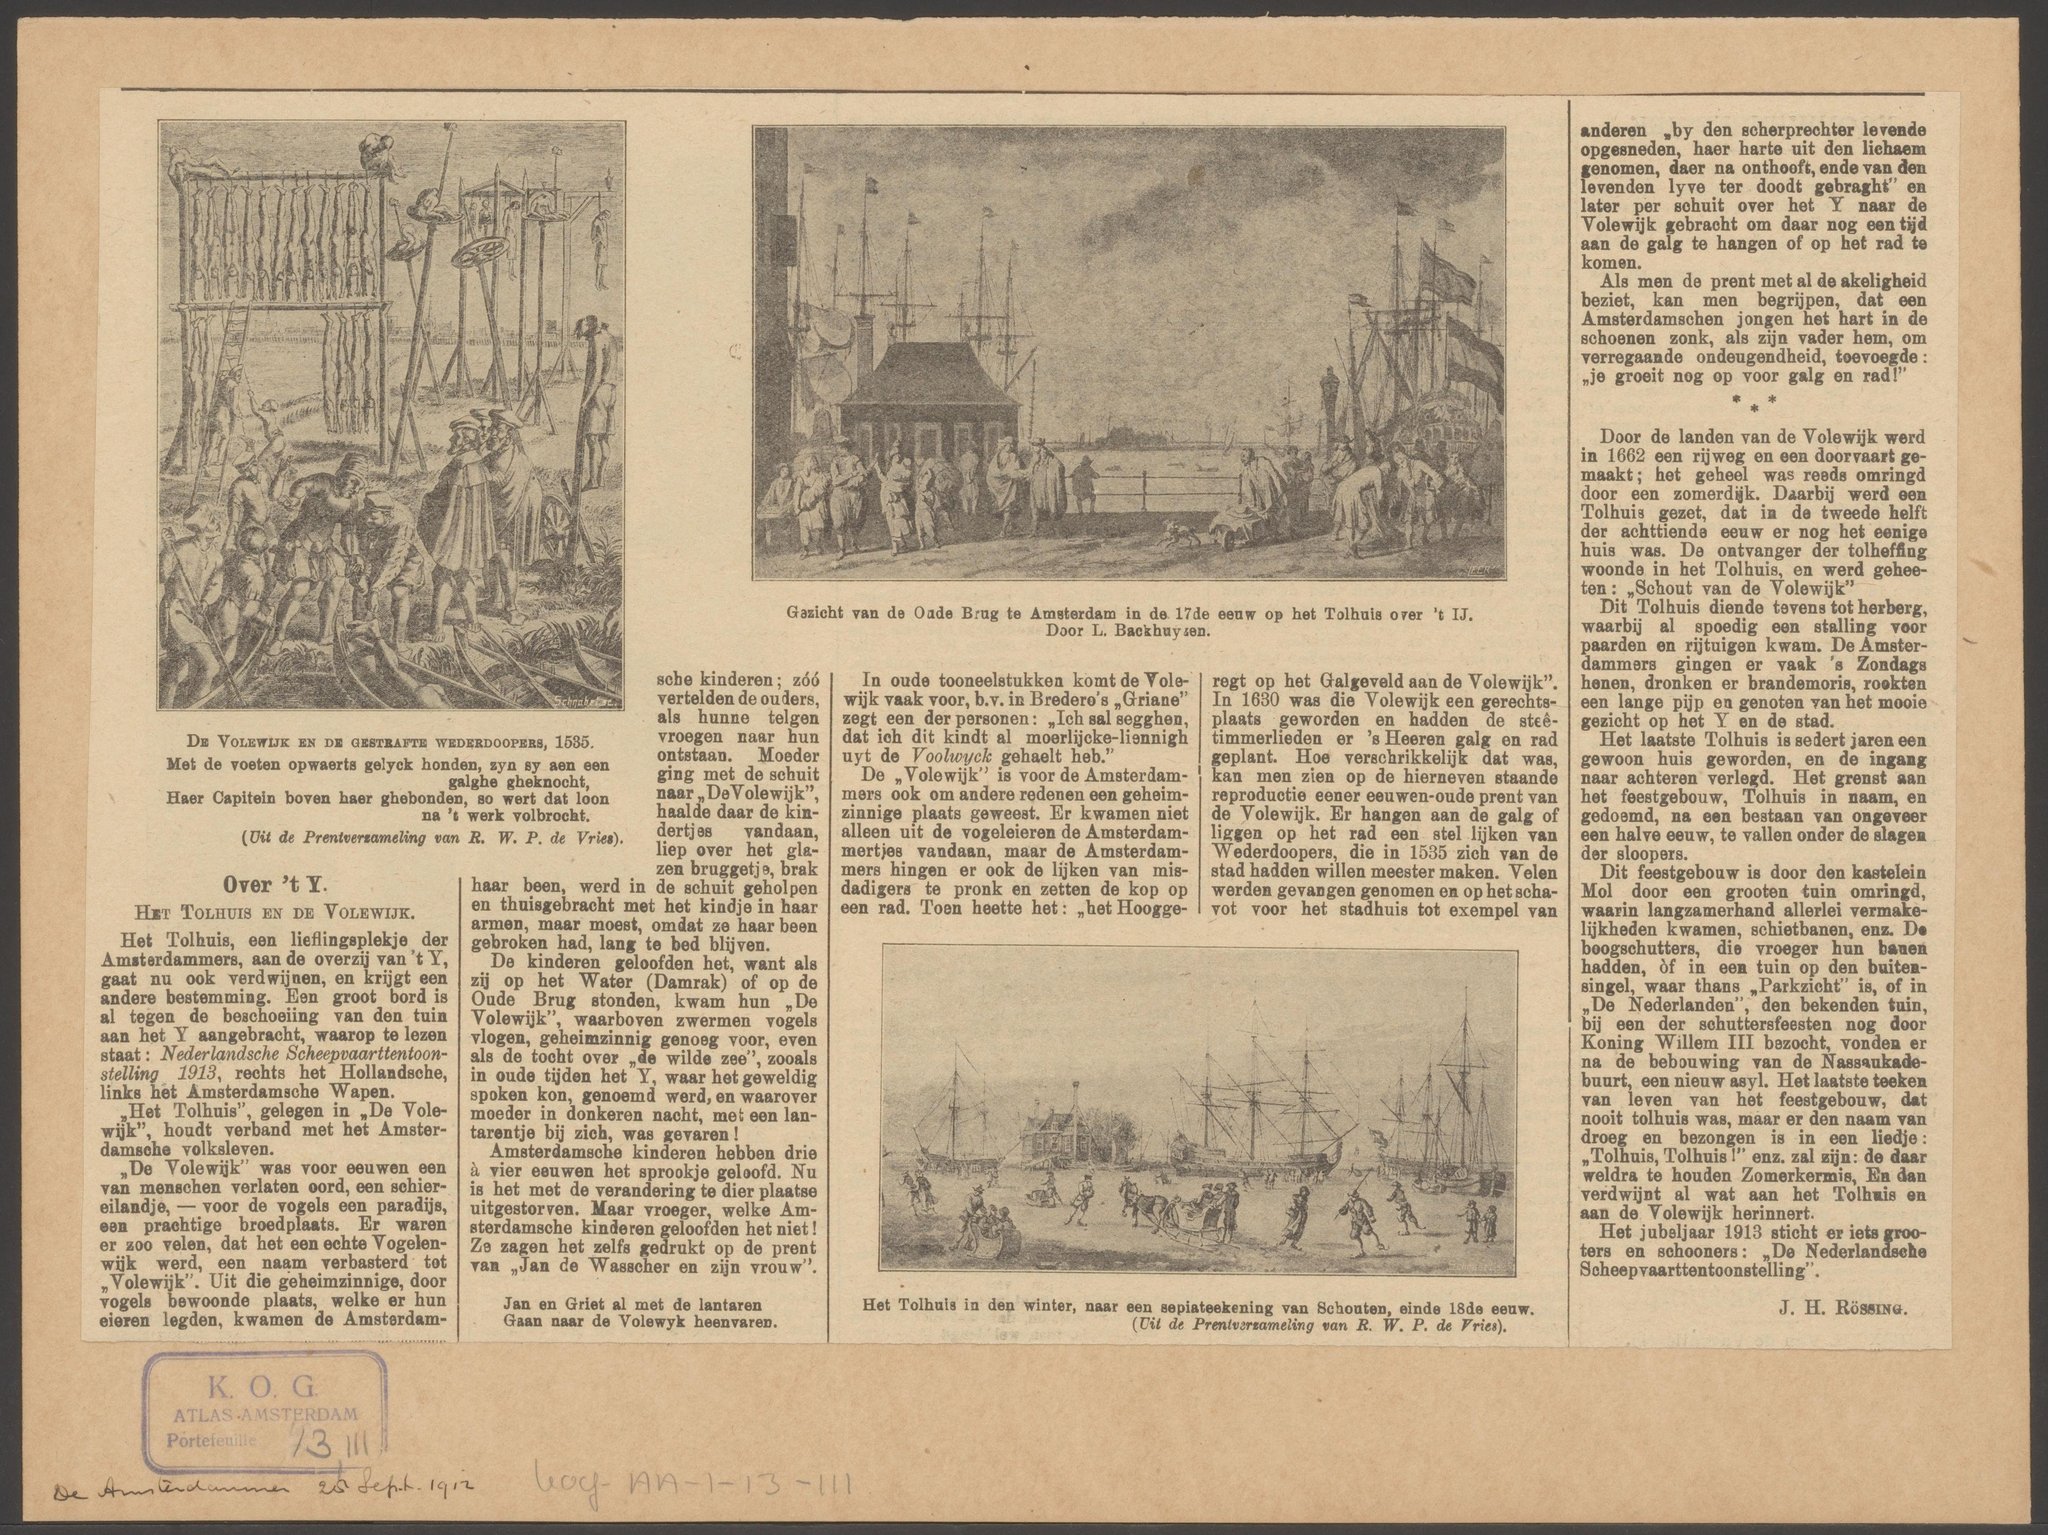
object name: photomechanical print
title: Gezichten op en bij het Tolhuis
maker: Anonymous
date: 1912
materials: paper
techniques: letterpress printing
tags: instruments of torture, execution or punishment: gallows, city-view in general; 'veduta', toll gate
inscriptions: collector's mark: ‘13,111’ Lugt 1641b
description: Onderwerpsrubriek binnen de Atlas Amsterdam: Taanstraat, Teertuinen (Nieuwe), Thorbeckeplein, Tolhuis, Tuinstraat (Kromme), Turfmarkt (Oude), Uilenburgergracht, Uilenburgerstraat, Utrechtsestraat.